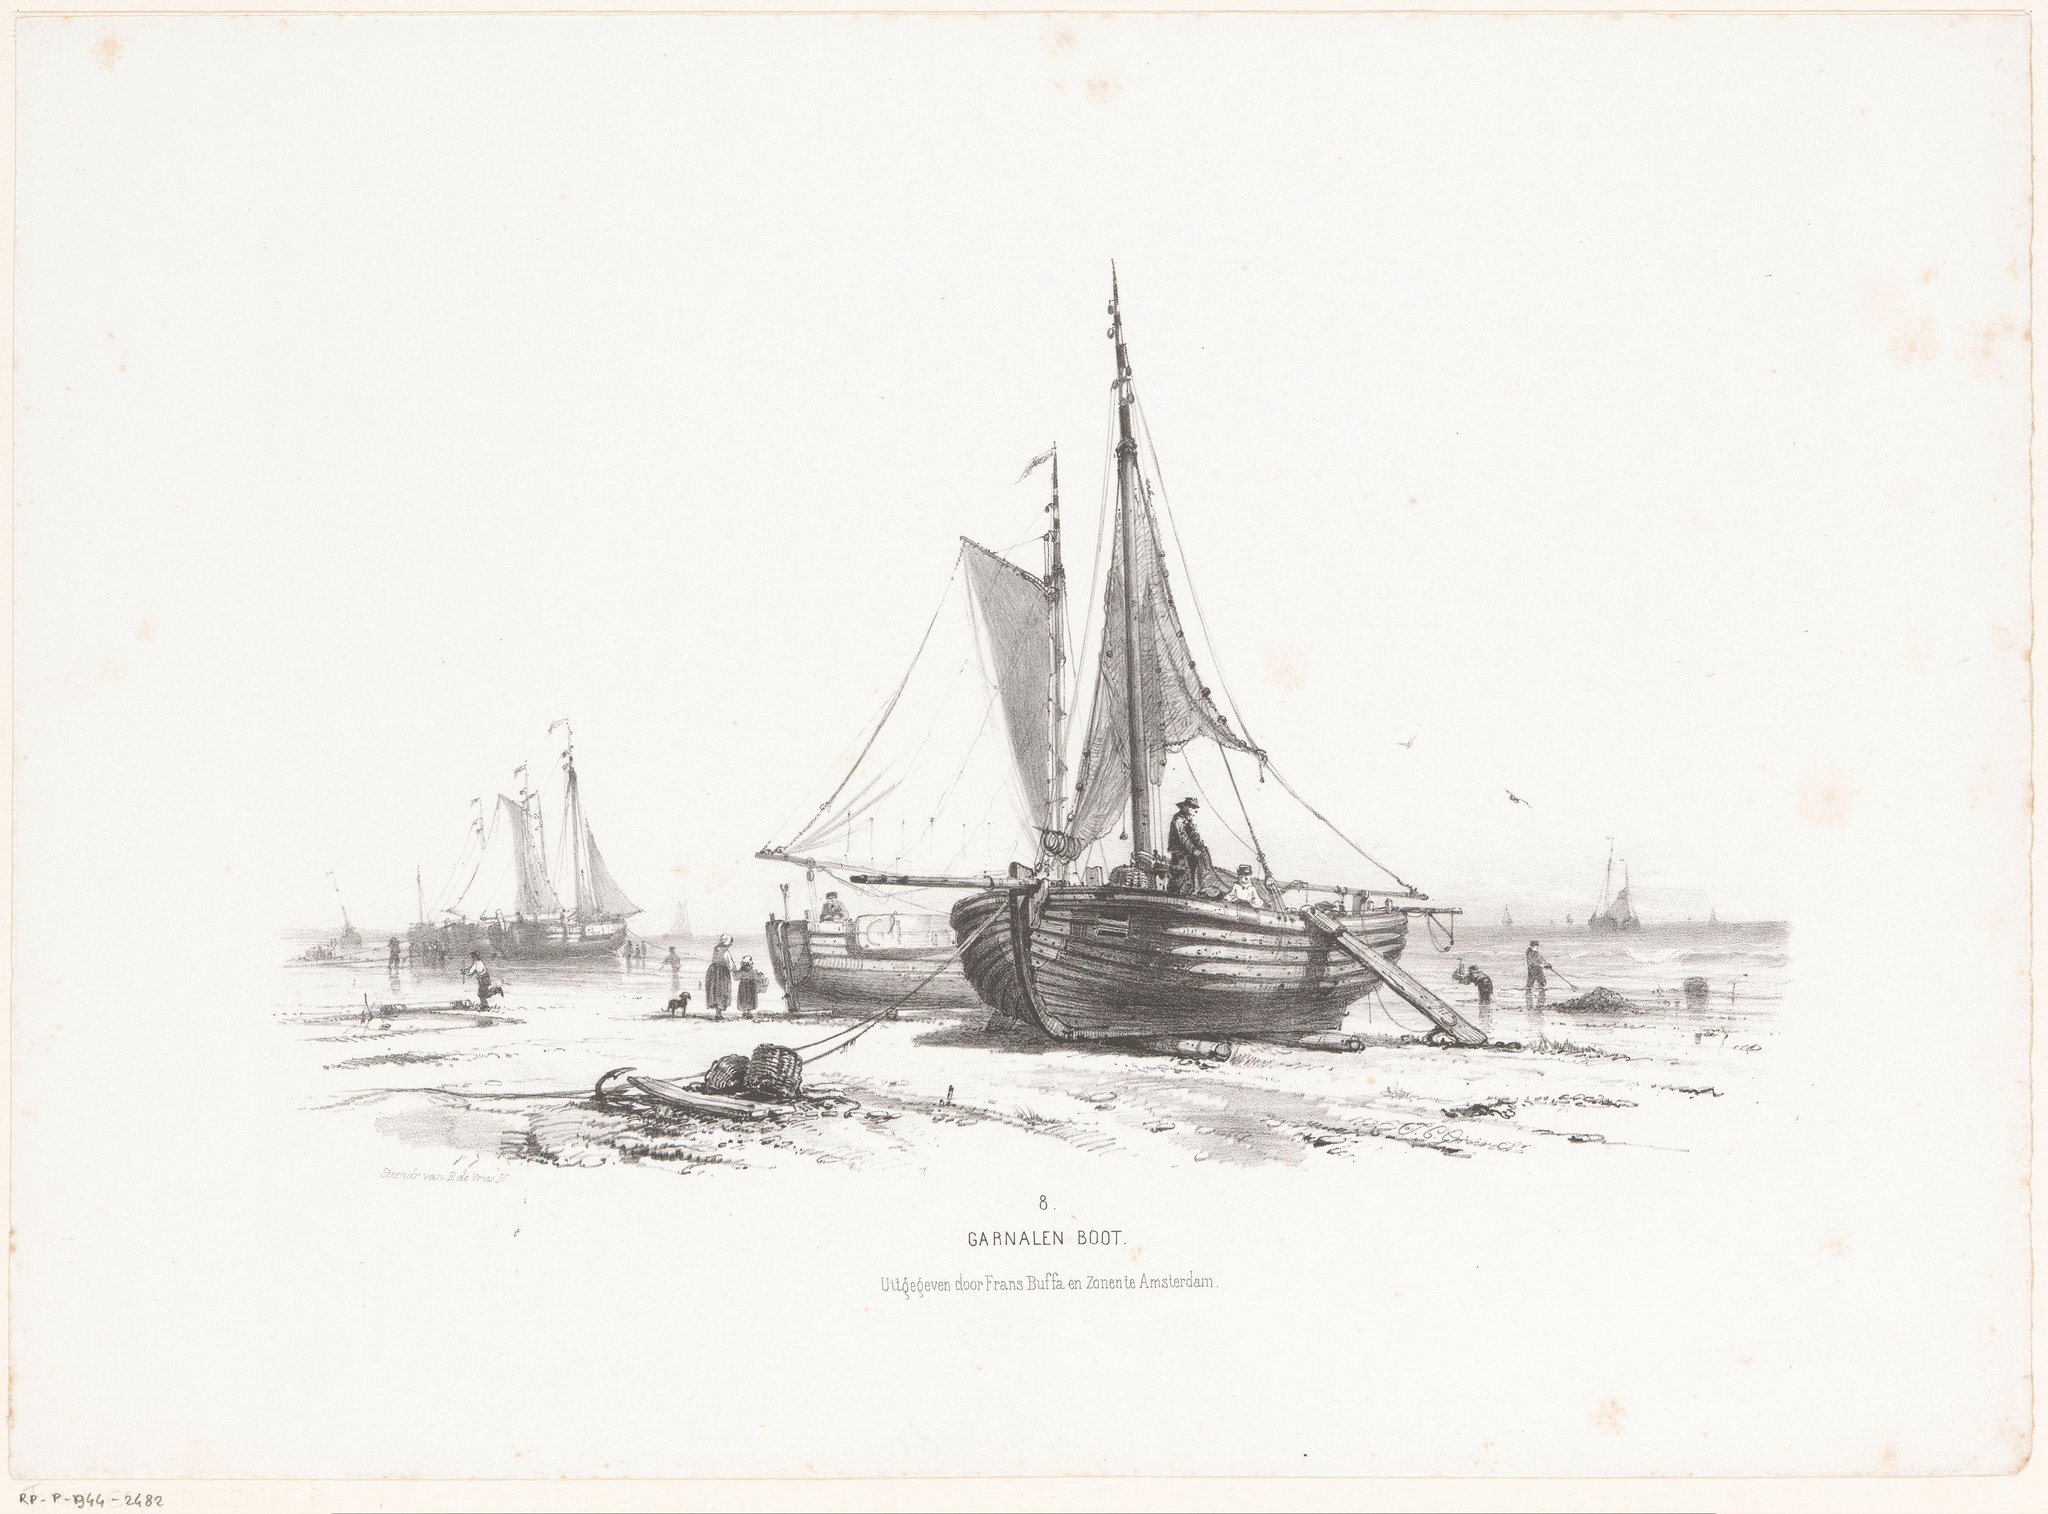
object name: print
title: Garnalenboot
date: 1860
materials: paper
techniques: lithograph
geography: amsterdam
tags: sailing-ship, sailing-boat, ships, boats on land, beached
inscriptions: collector's mark: Lugt 2228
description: Prent uit een twaalfdelige serie, getiteld 'Studiën van Hollandsche Schepen naar de Natuur geteekend en op Steen gebracht door J.C. Greive Jr., uitgegeven door Frans Buffa en Zonen in Amsterdam.